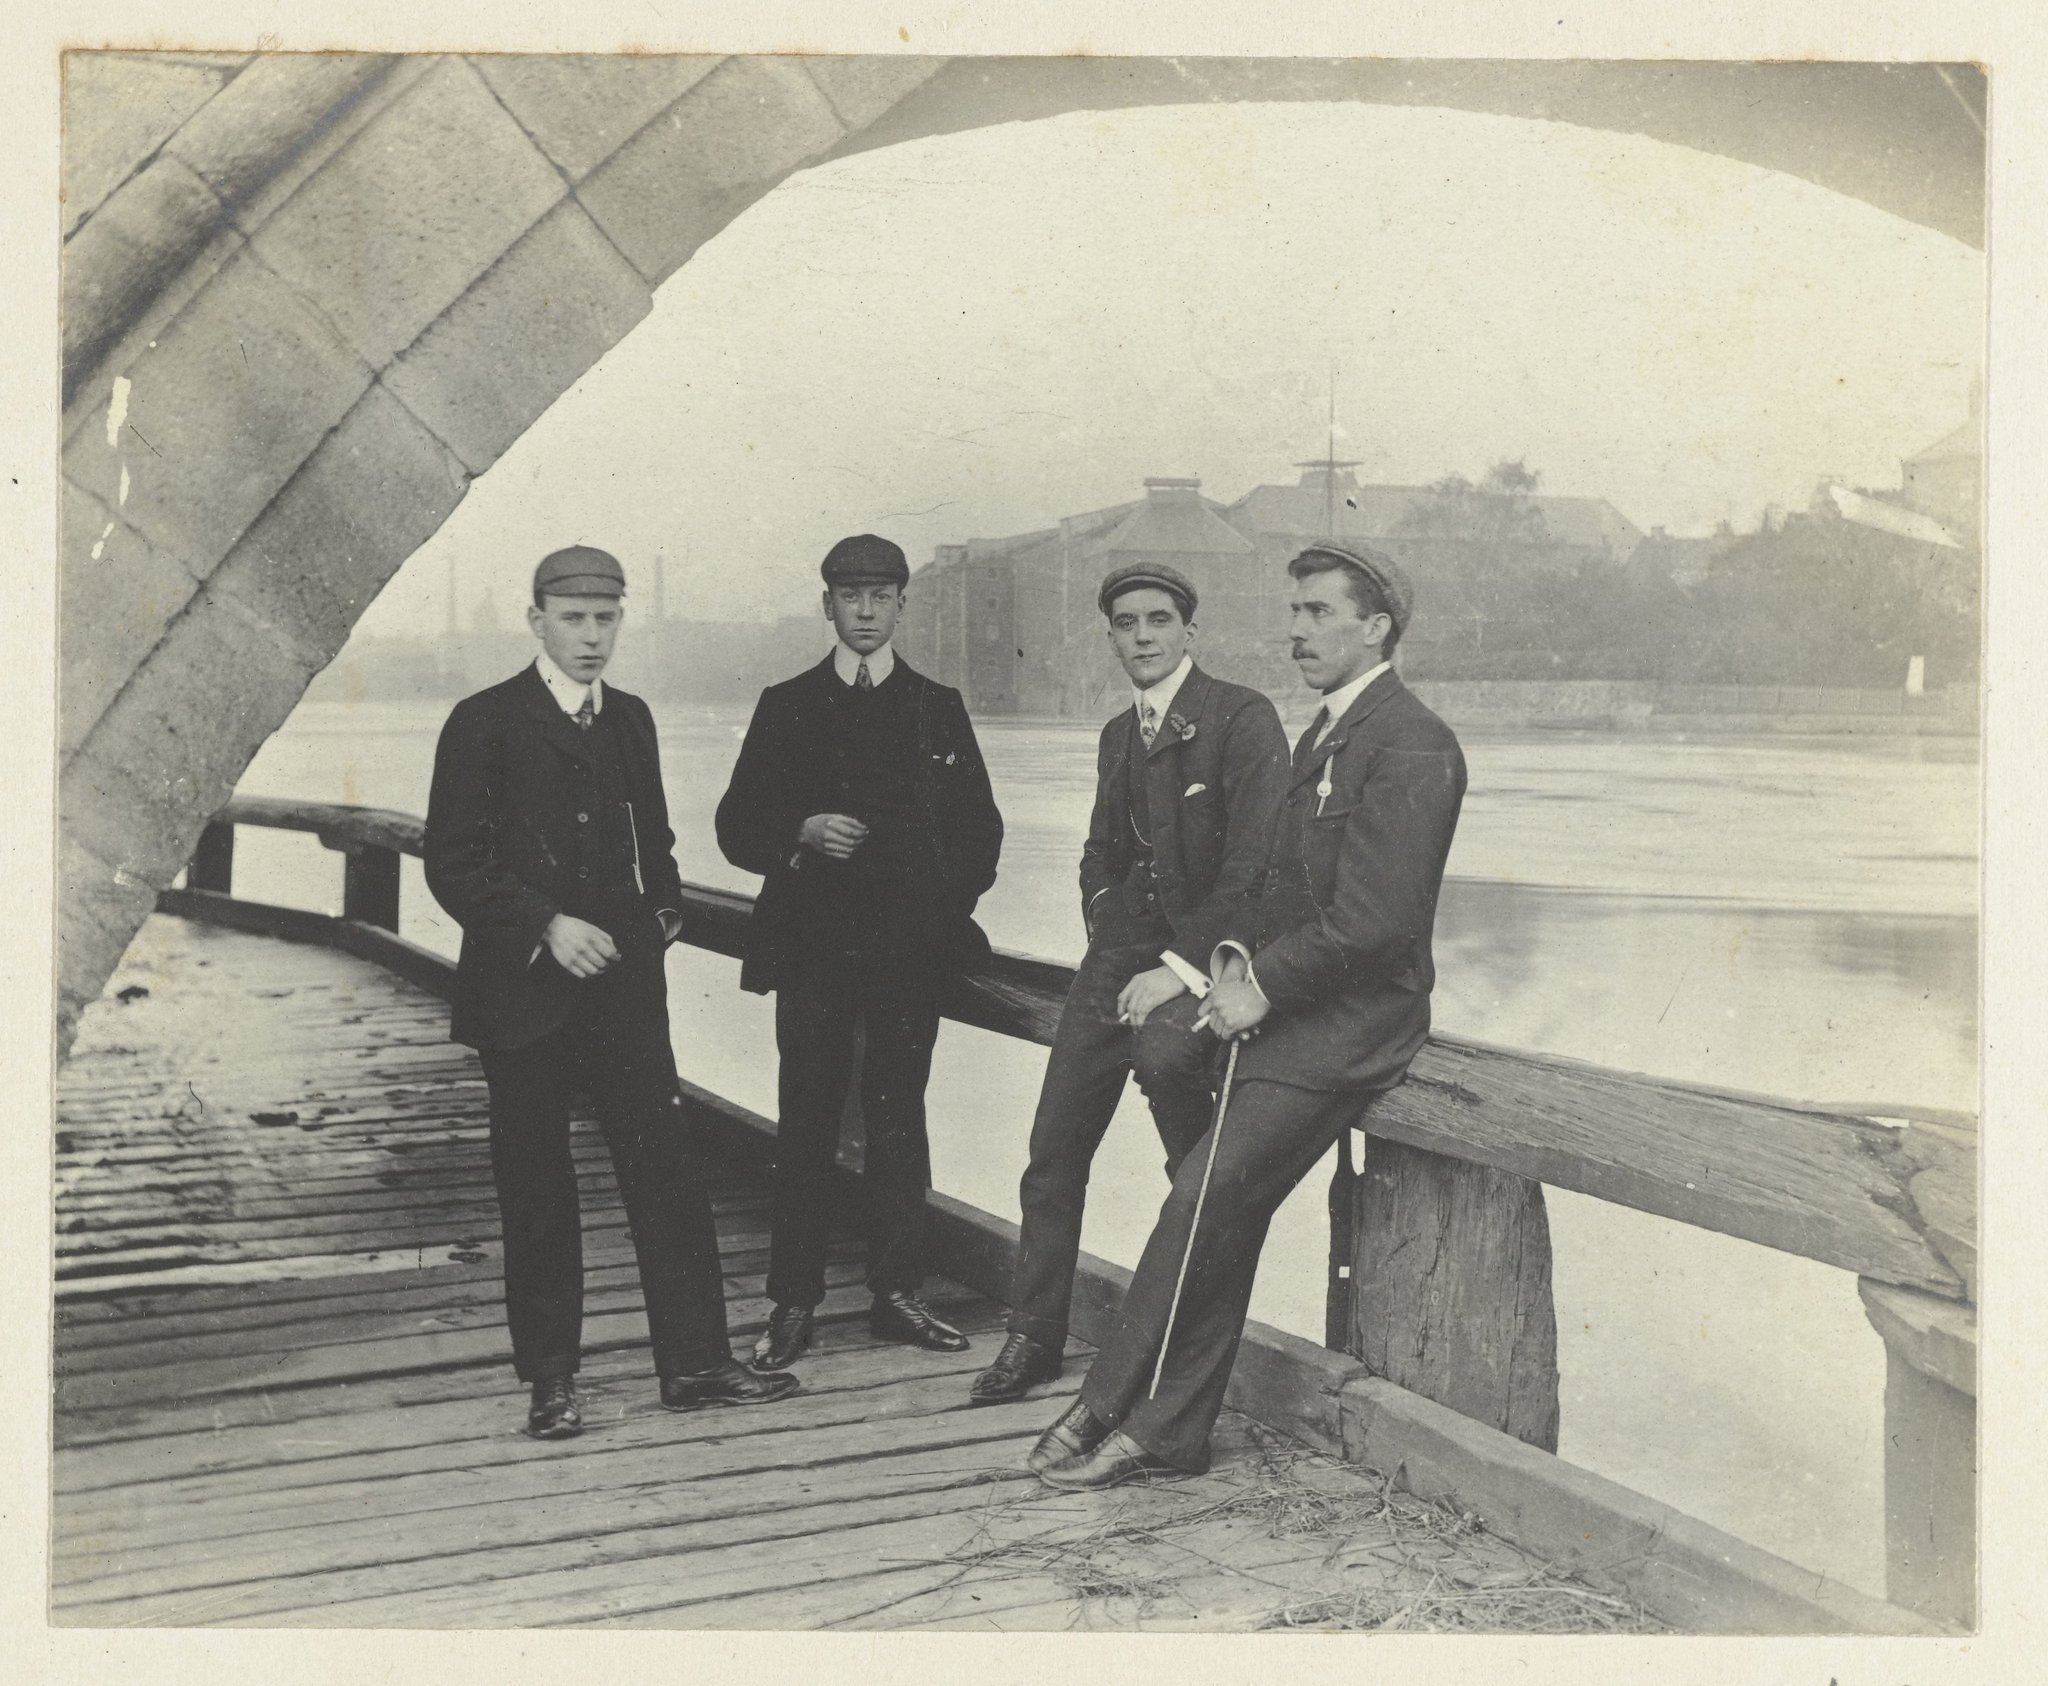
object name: photograph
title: De vrienden van Dolph Kessler poseren onder Gainsborough Bridge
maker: geldolph adriaan kessler (dolph)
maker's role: fotograaf, industrieel, voetballer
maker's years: 1884-1945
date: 1903-1904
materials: cardboard, photographic support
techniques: gelatin silver print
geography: gainsborough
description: De vrienden van Dolph Kessler poseren onder Gainsborough Bridge, op de achtergrond de rivier de Trent. Onderdeel van het fotoalbum van Dolph Kessler met opnamen die hij maakte tijdens zijn verblijf in Engeland en op een wereldreis die hij als secretaris van Henri Deterding (directeur Koninklijke Olie) ondernam naar Nederlands-Indië, Japan, China en de Verenigde Staten, tussen 1906 en 1908.